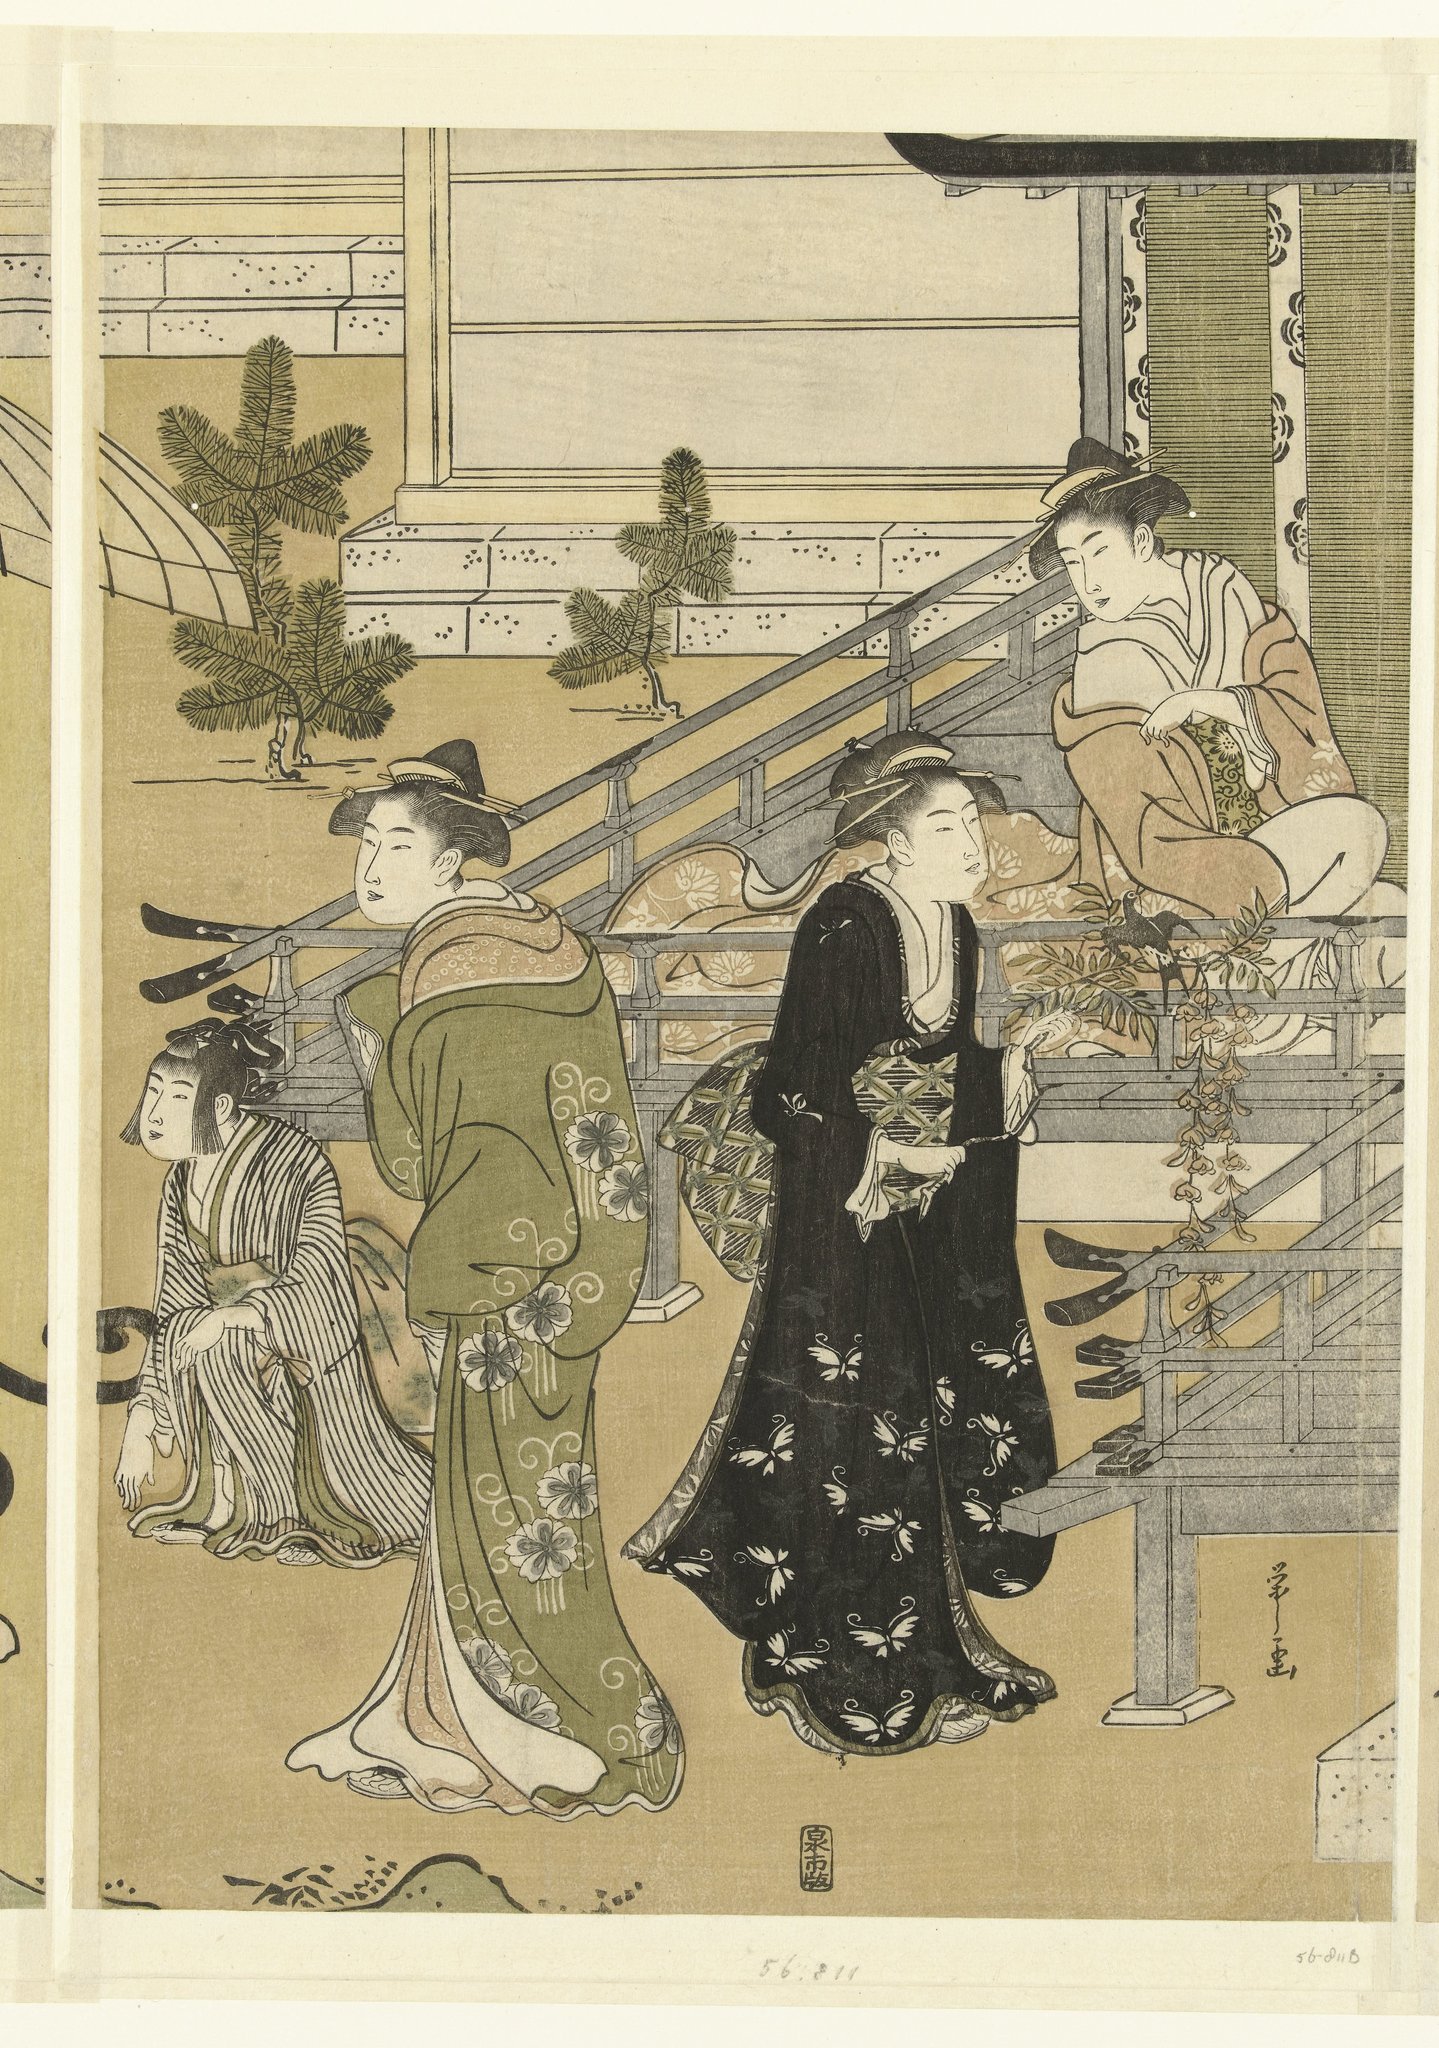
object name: print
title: Het bezoek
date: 1788-1792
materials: paper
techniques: woodcut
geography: tokyo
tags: plants; vegetation, dignitary at court - bb - female dignitary: lady-in-waiting, loggia, verandah, porch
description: Knielend meisje en vrouw staand met de rug naar hofdame in zwarte kimono en tak blauwe regen waarop nagemaakte vogel; bij veranda waarop toekijkende vrouw.